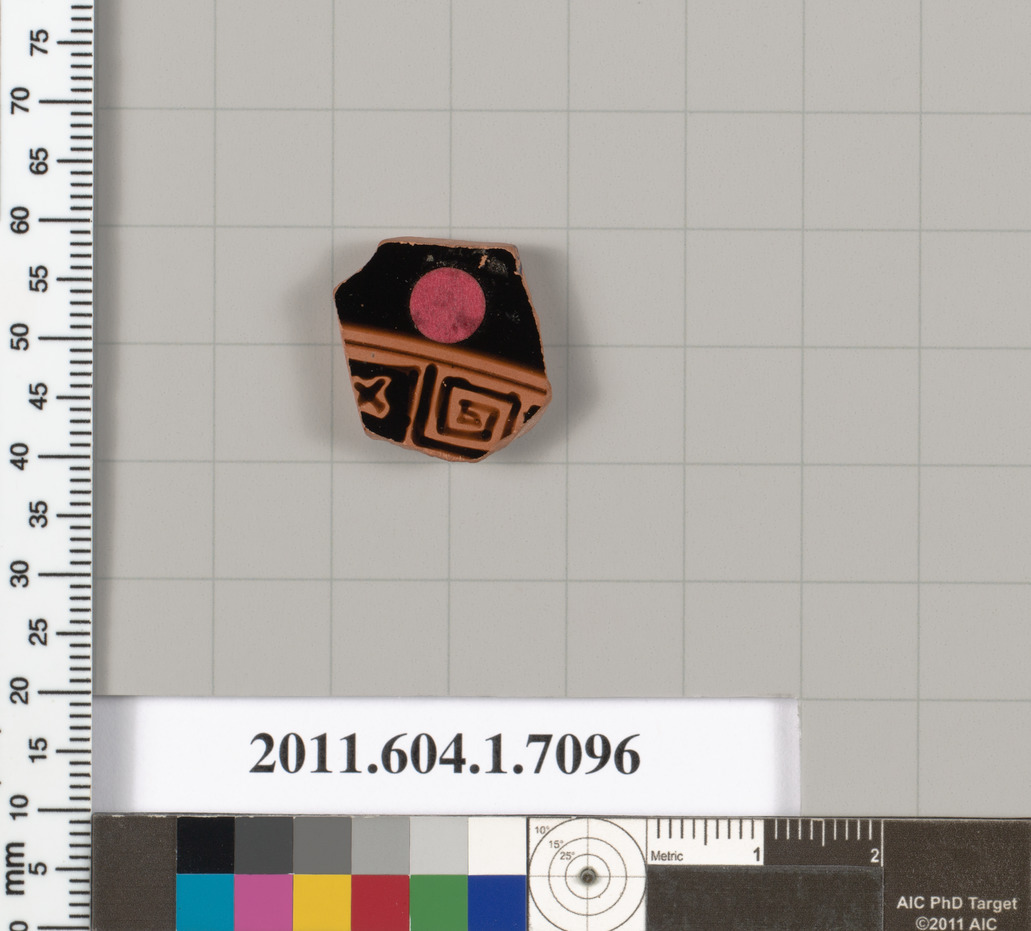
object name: kylix fragment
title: Terracotta fragment of a kylix (drinking cup)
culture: greek, attic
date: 500-480 BCE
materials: terracotta